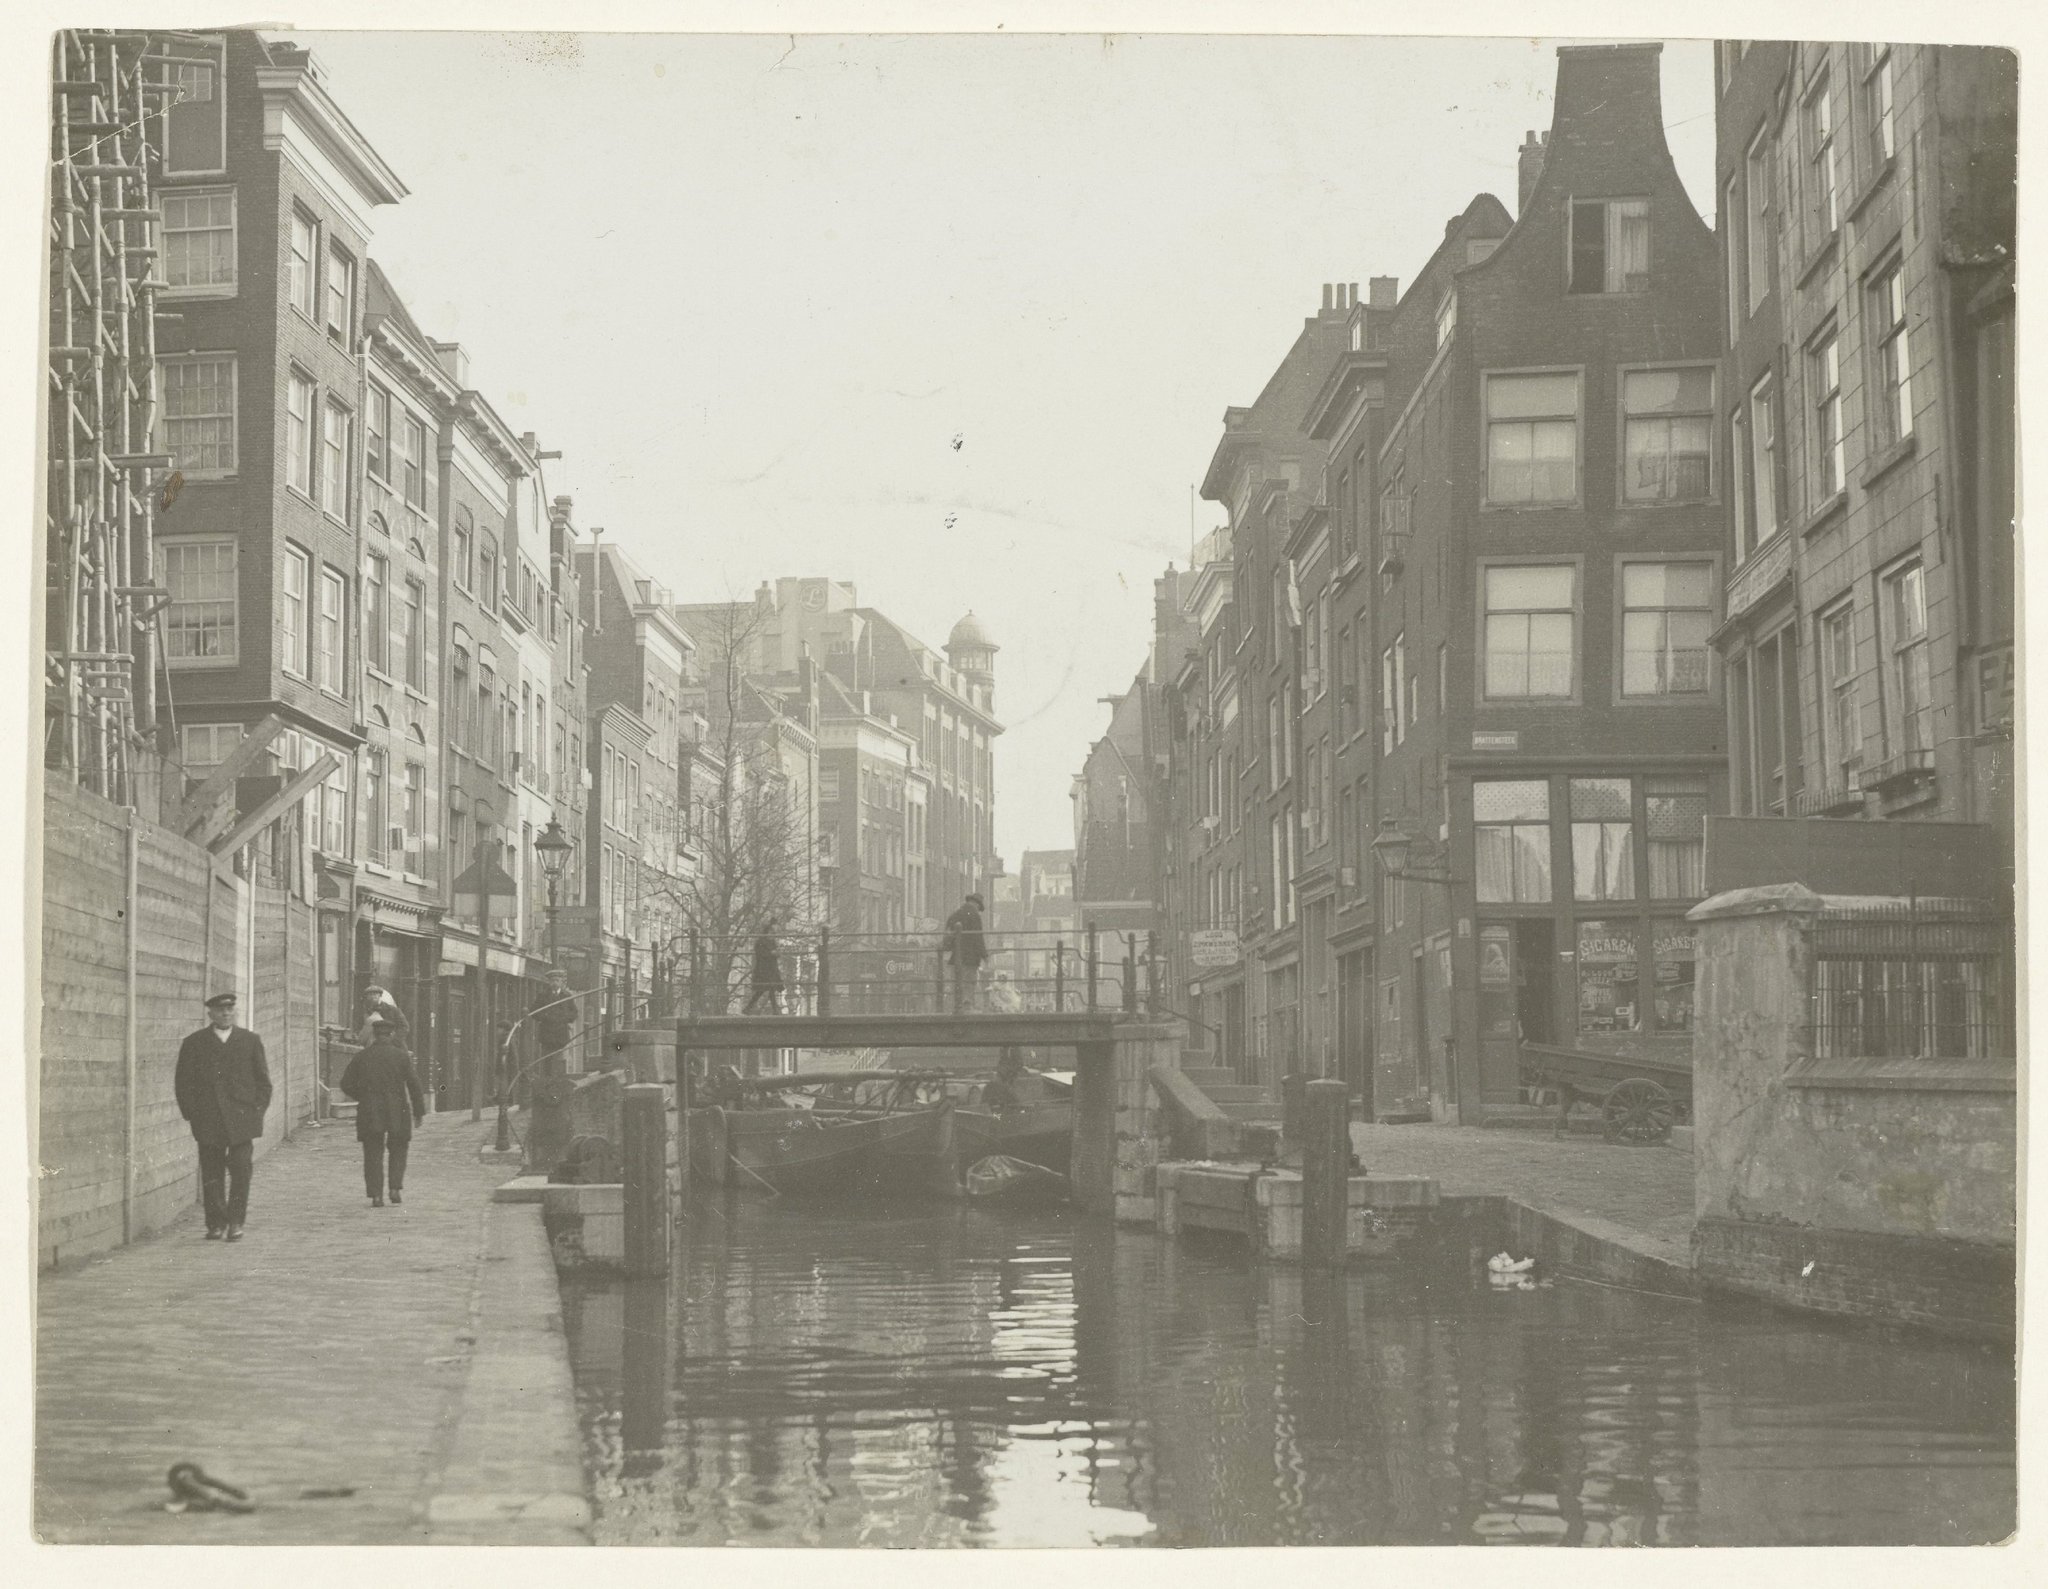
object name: photograph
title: Gezicht over de gracht en de Krattensteeg in Rotterdam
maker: Anonymous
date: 1880-1900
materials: paper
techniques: gelatin silver print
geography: netherlands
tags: canals, waters (in city)